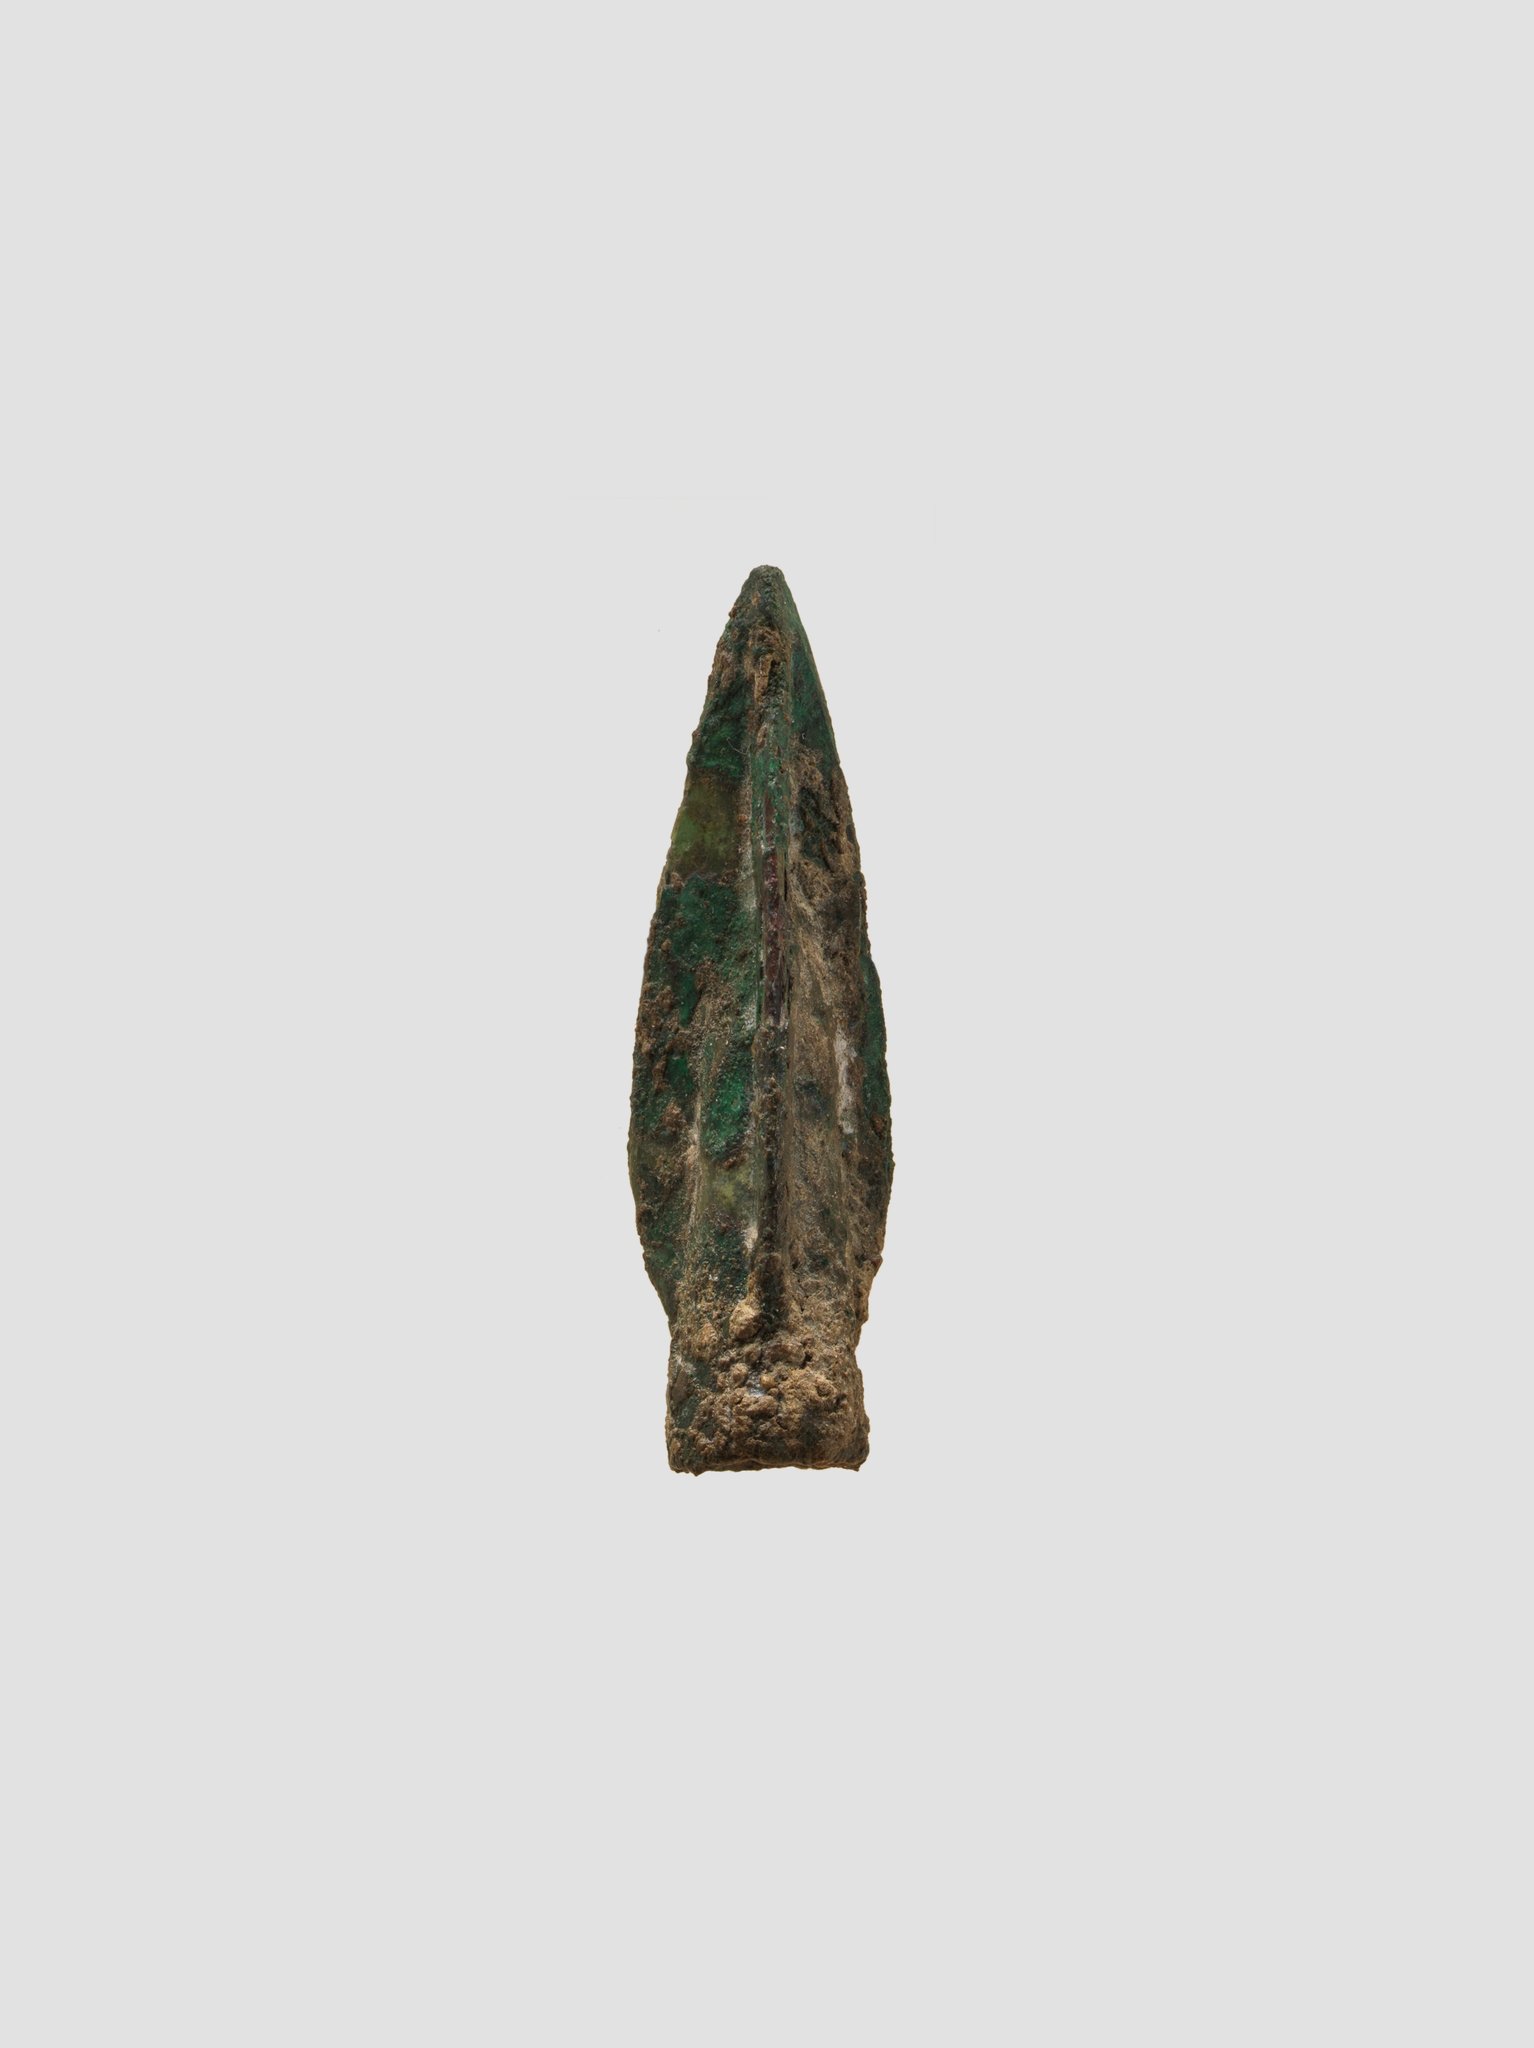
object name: arrowhead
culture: sasanian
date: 201-700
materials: bronze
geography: iran